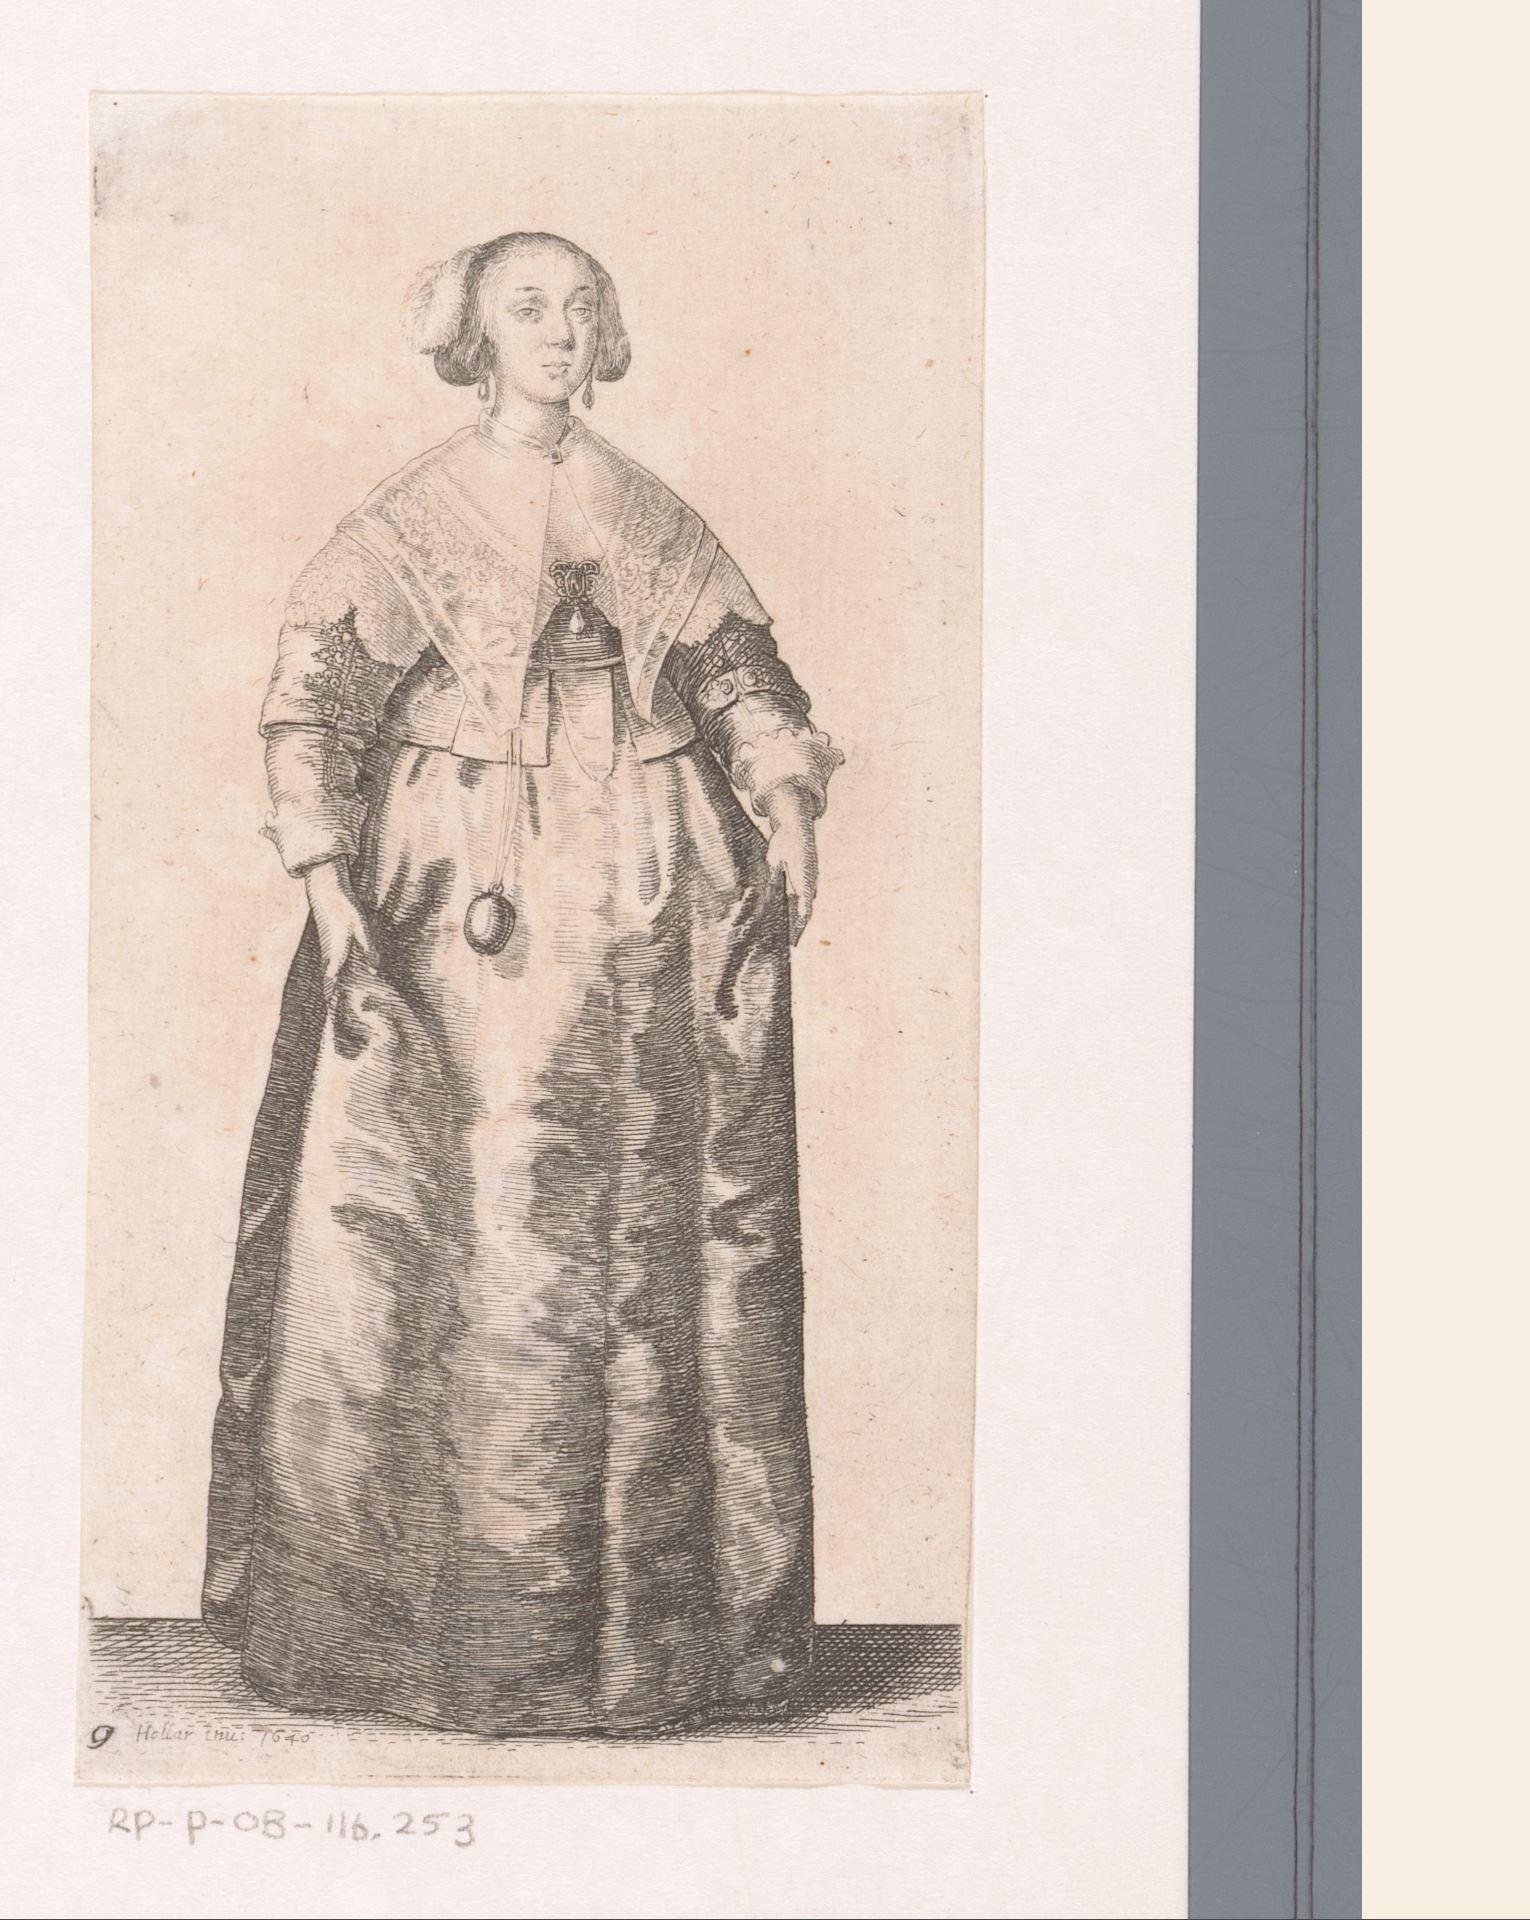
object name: costume print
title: Vrouwen gekleed volgens de Engelse mode, ca. 1640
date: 1640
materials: paper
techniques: etching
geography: london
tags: brooch, agraffe, clasp (+ women's clothes), neck-gear ~ clothing (neckerchief) (+ women's clothes), europeans: englishmen (+ women), styles of hairdress - aa - ~ women, fashion, clothing (+ lace used for clothes), neck-gear: collar (+ women's clothes), fashion plates, clothes, costume (+ women's clothes), pomander, musk ball - aa - (for) women, piece of clothing covering the breast or décolleté (+ women's clothes), dress, gown (+ women's clothes), pearl; pearl necklace (+ women's clothes)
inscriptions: collector's mark: Lugt 2228, collector's mark: Lugt 2760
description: Engelse dame met glad naar achteren gekamd haar, dat naar binnen gekruld tot over de oren valt. Rechts op het achterhoofd is een veer in het haar gestoken. Gekleed in een japon, dat rondom de schouders is afgezet met geschulpt kant, daaroverheen een transparante halsdoek, die bij de hals wordt gesloten met een sieraad. In de taille een gestrikte ceintuur waar een reukbal aan is bevestigd.